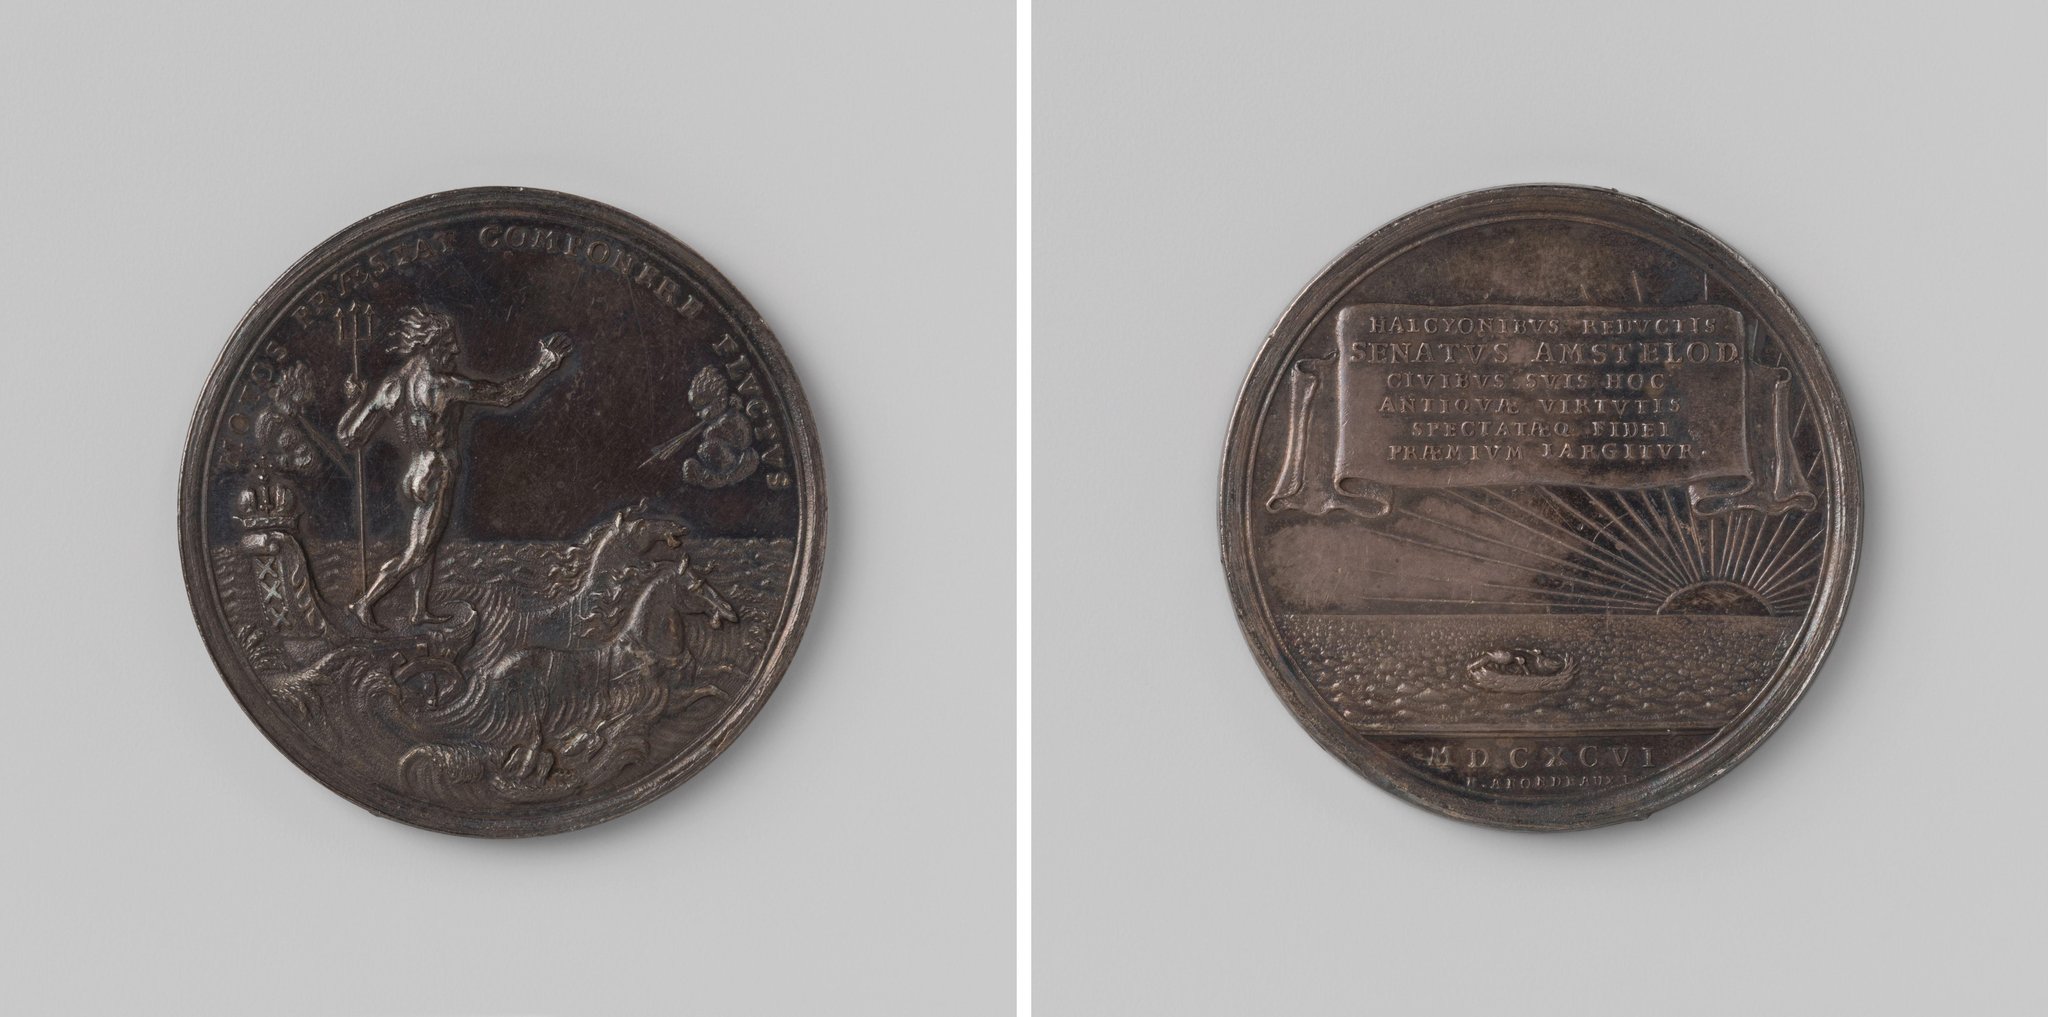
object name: history medal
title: Stillen van het aansprekersoproer te Amsterdam, penning aan de gewapende burgers vereerd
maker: reynier arondeaux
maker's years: 1678-1727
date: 1696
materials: silver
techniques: striking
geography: amsterdam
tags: amsterdam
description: Zilveren penning. Voorzijde: Neptunus met drietand staande op zijn wagen in een woelige zee straft vertoornd de losgelaten stormwinden, op voorgrond twee vogels die uit nest vallen binnen omschrift. Keerzijde: twee vogels in nest op kalme zee, terwijl zon opkomt onder wimpel met opschrift; afsnede: jaartal.